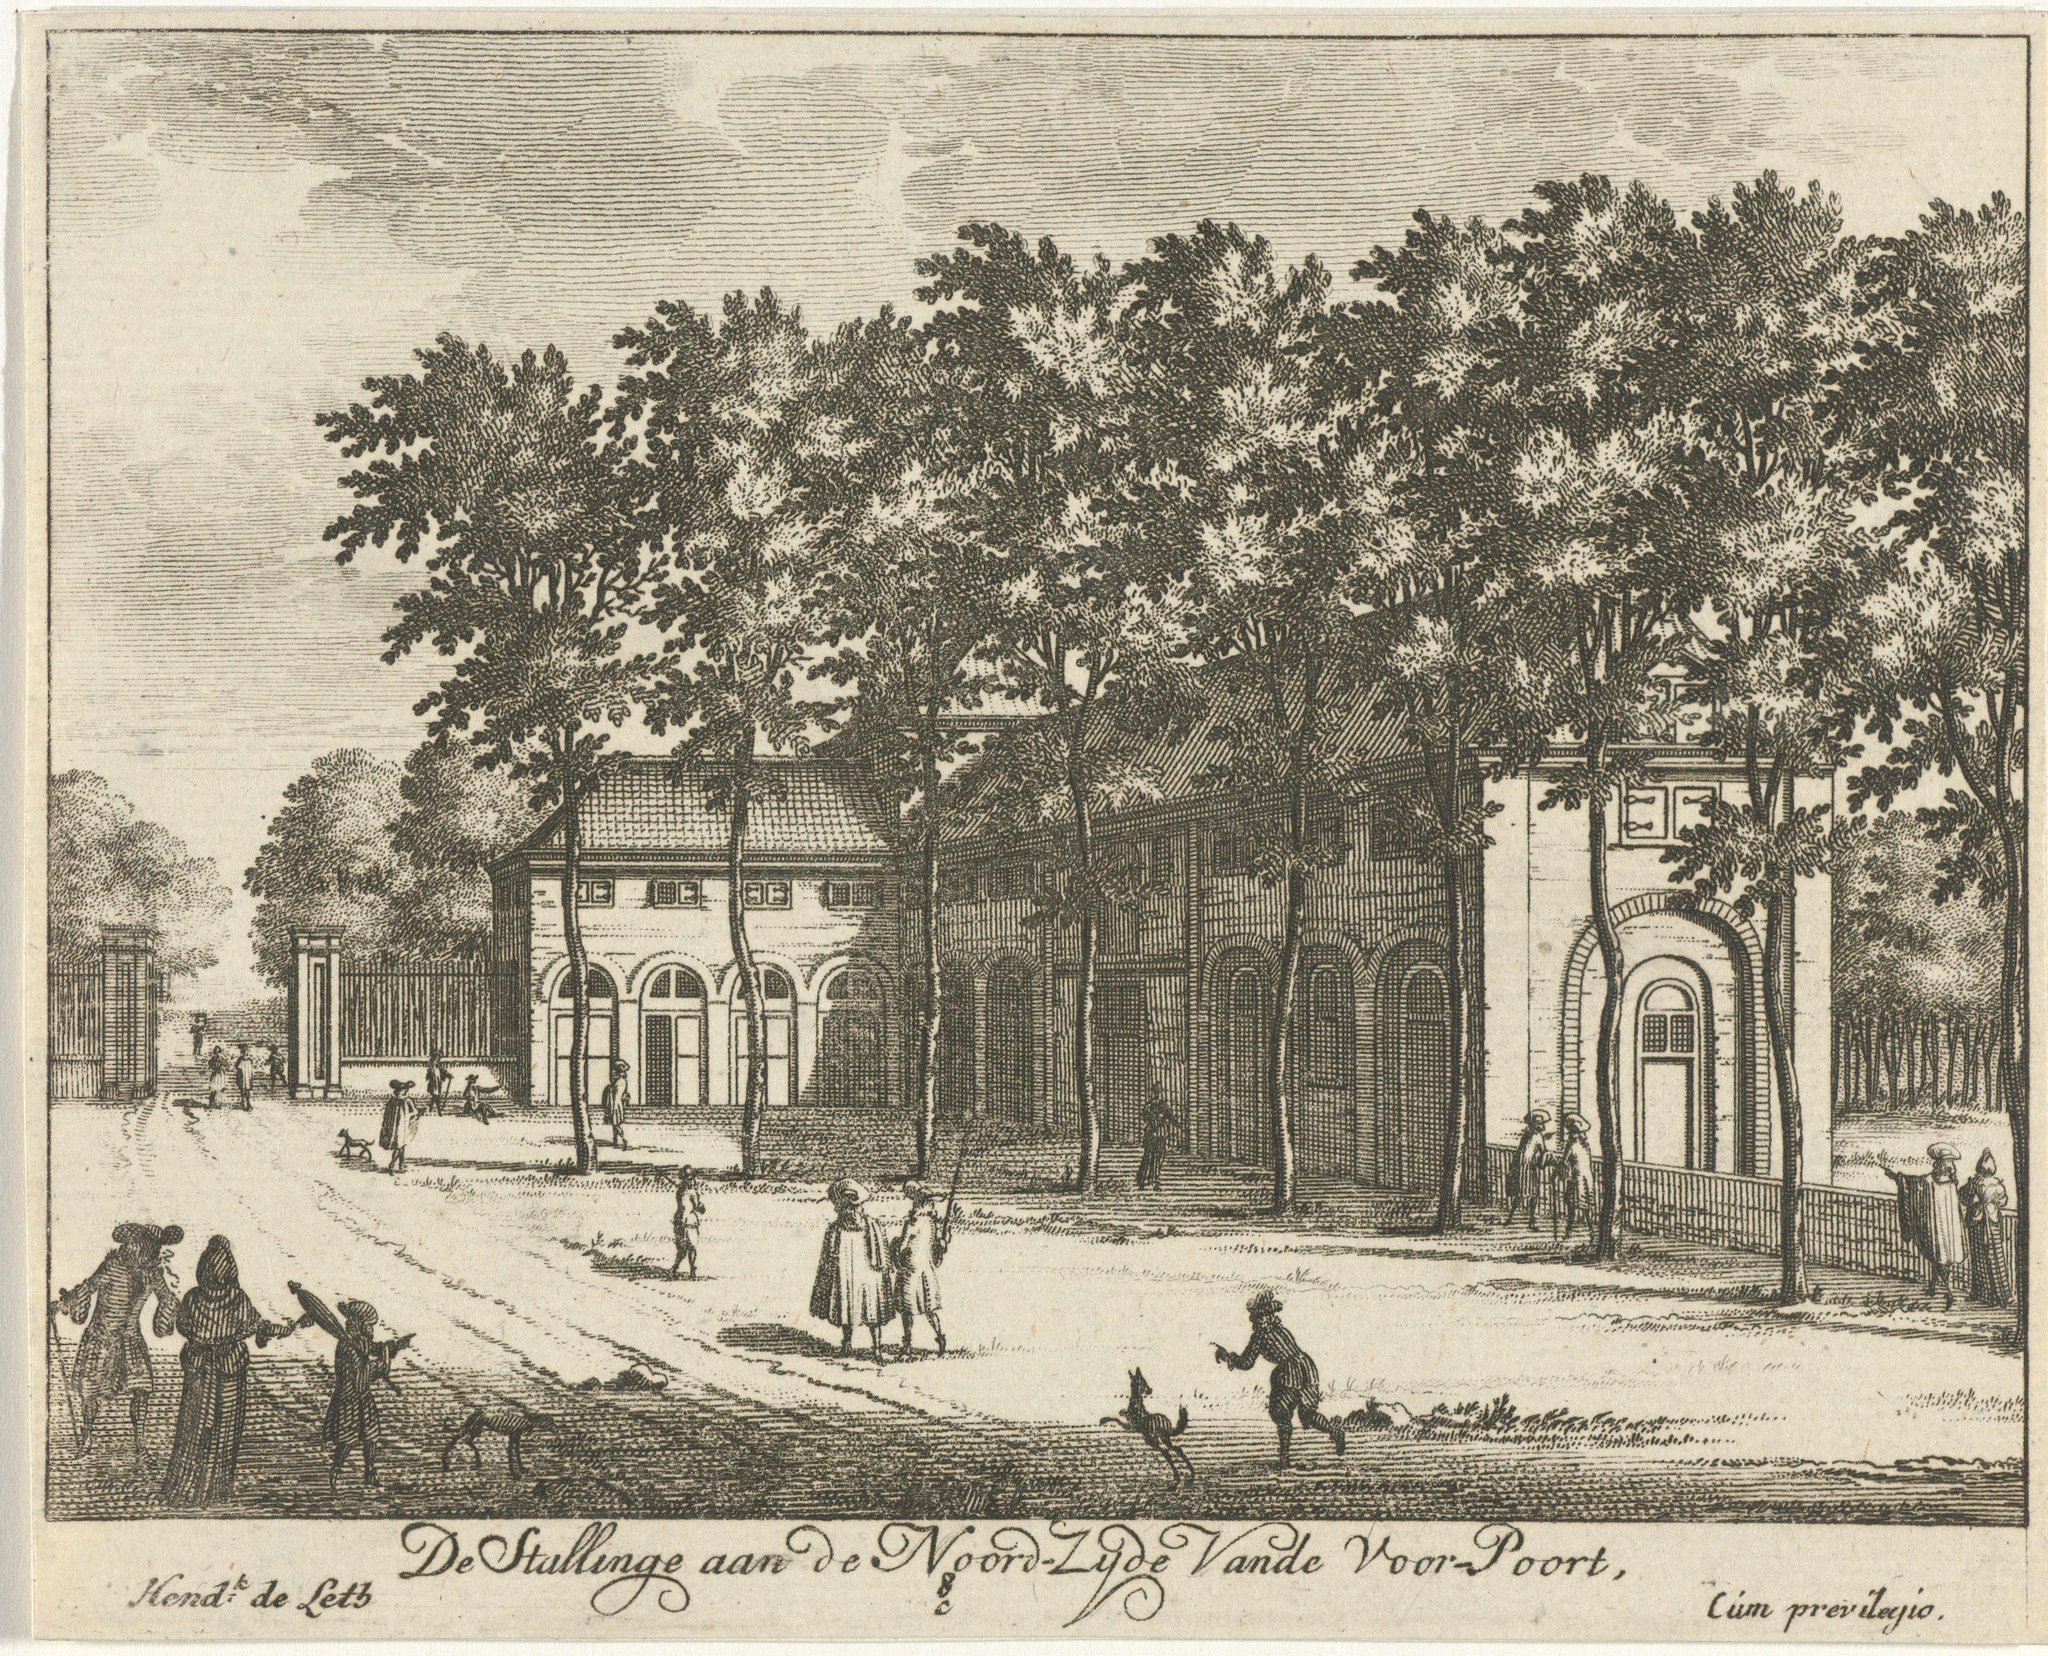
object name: print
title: Stallen aan de noordzijde van Paleis Soestdijk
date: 1725-1747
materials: paper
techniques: etching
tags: palace, stall, stable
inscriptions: collector's mark: Lugt 2228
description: Gezicht op de stallen aan de noordzijde van Paleis Soestdijk met op de voorgrond wandelende figuren. De prent maakt deel uit van een serie met zestien gezichten op Paleis Soestdijk en het bijbehorende landgoed.